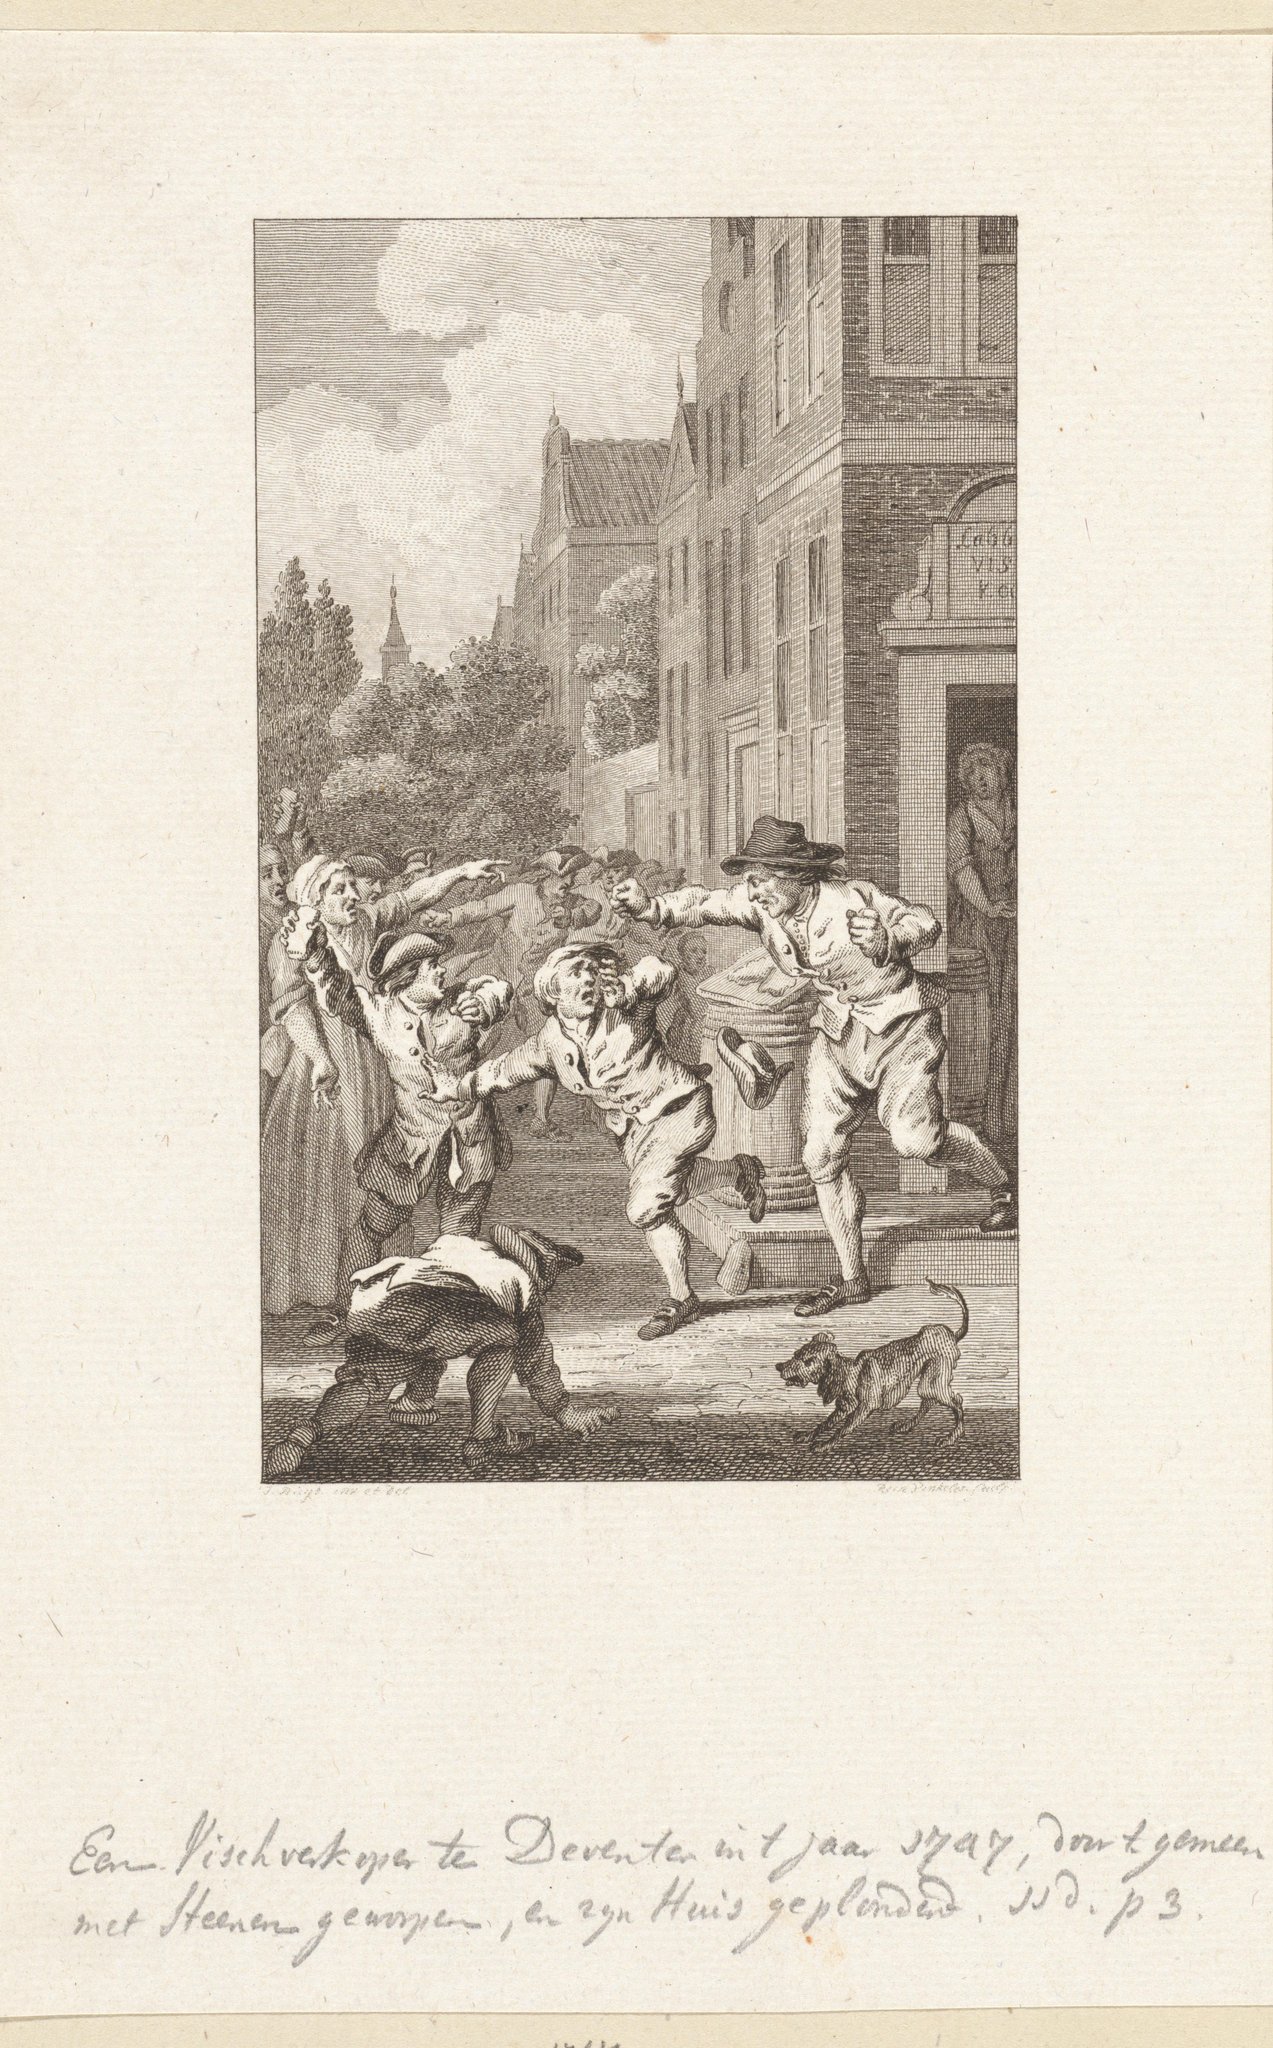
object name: print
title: Een vischverkooper te Deventer door 't gemeen met steenen geworpen 1747. pr.dr: v.a.l.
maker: reinier vinkeles (i)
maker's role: draughtsman, print maker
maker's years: 1741-1816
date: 1751-1816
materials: paper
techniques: engraving, etching